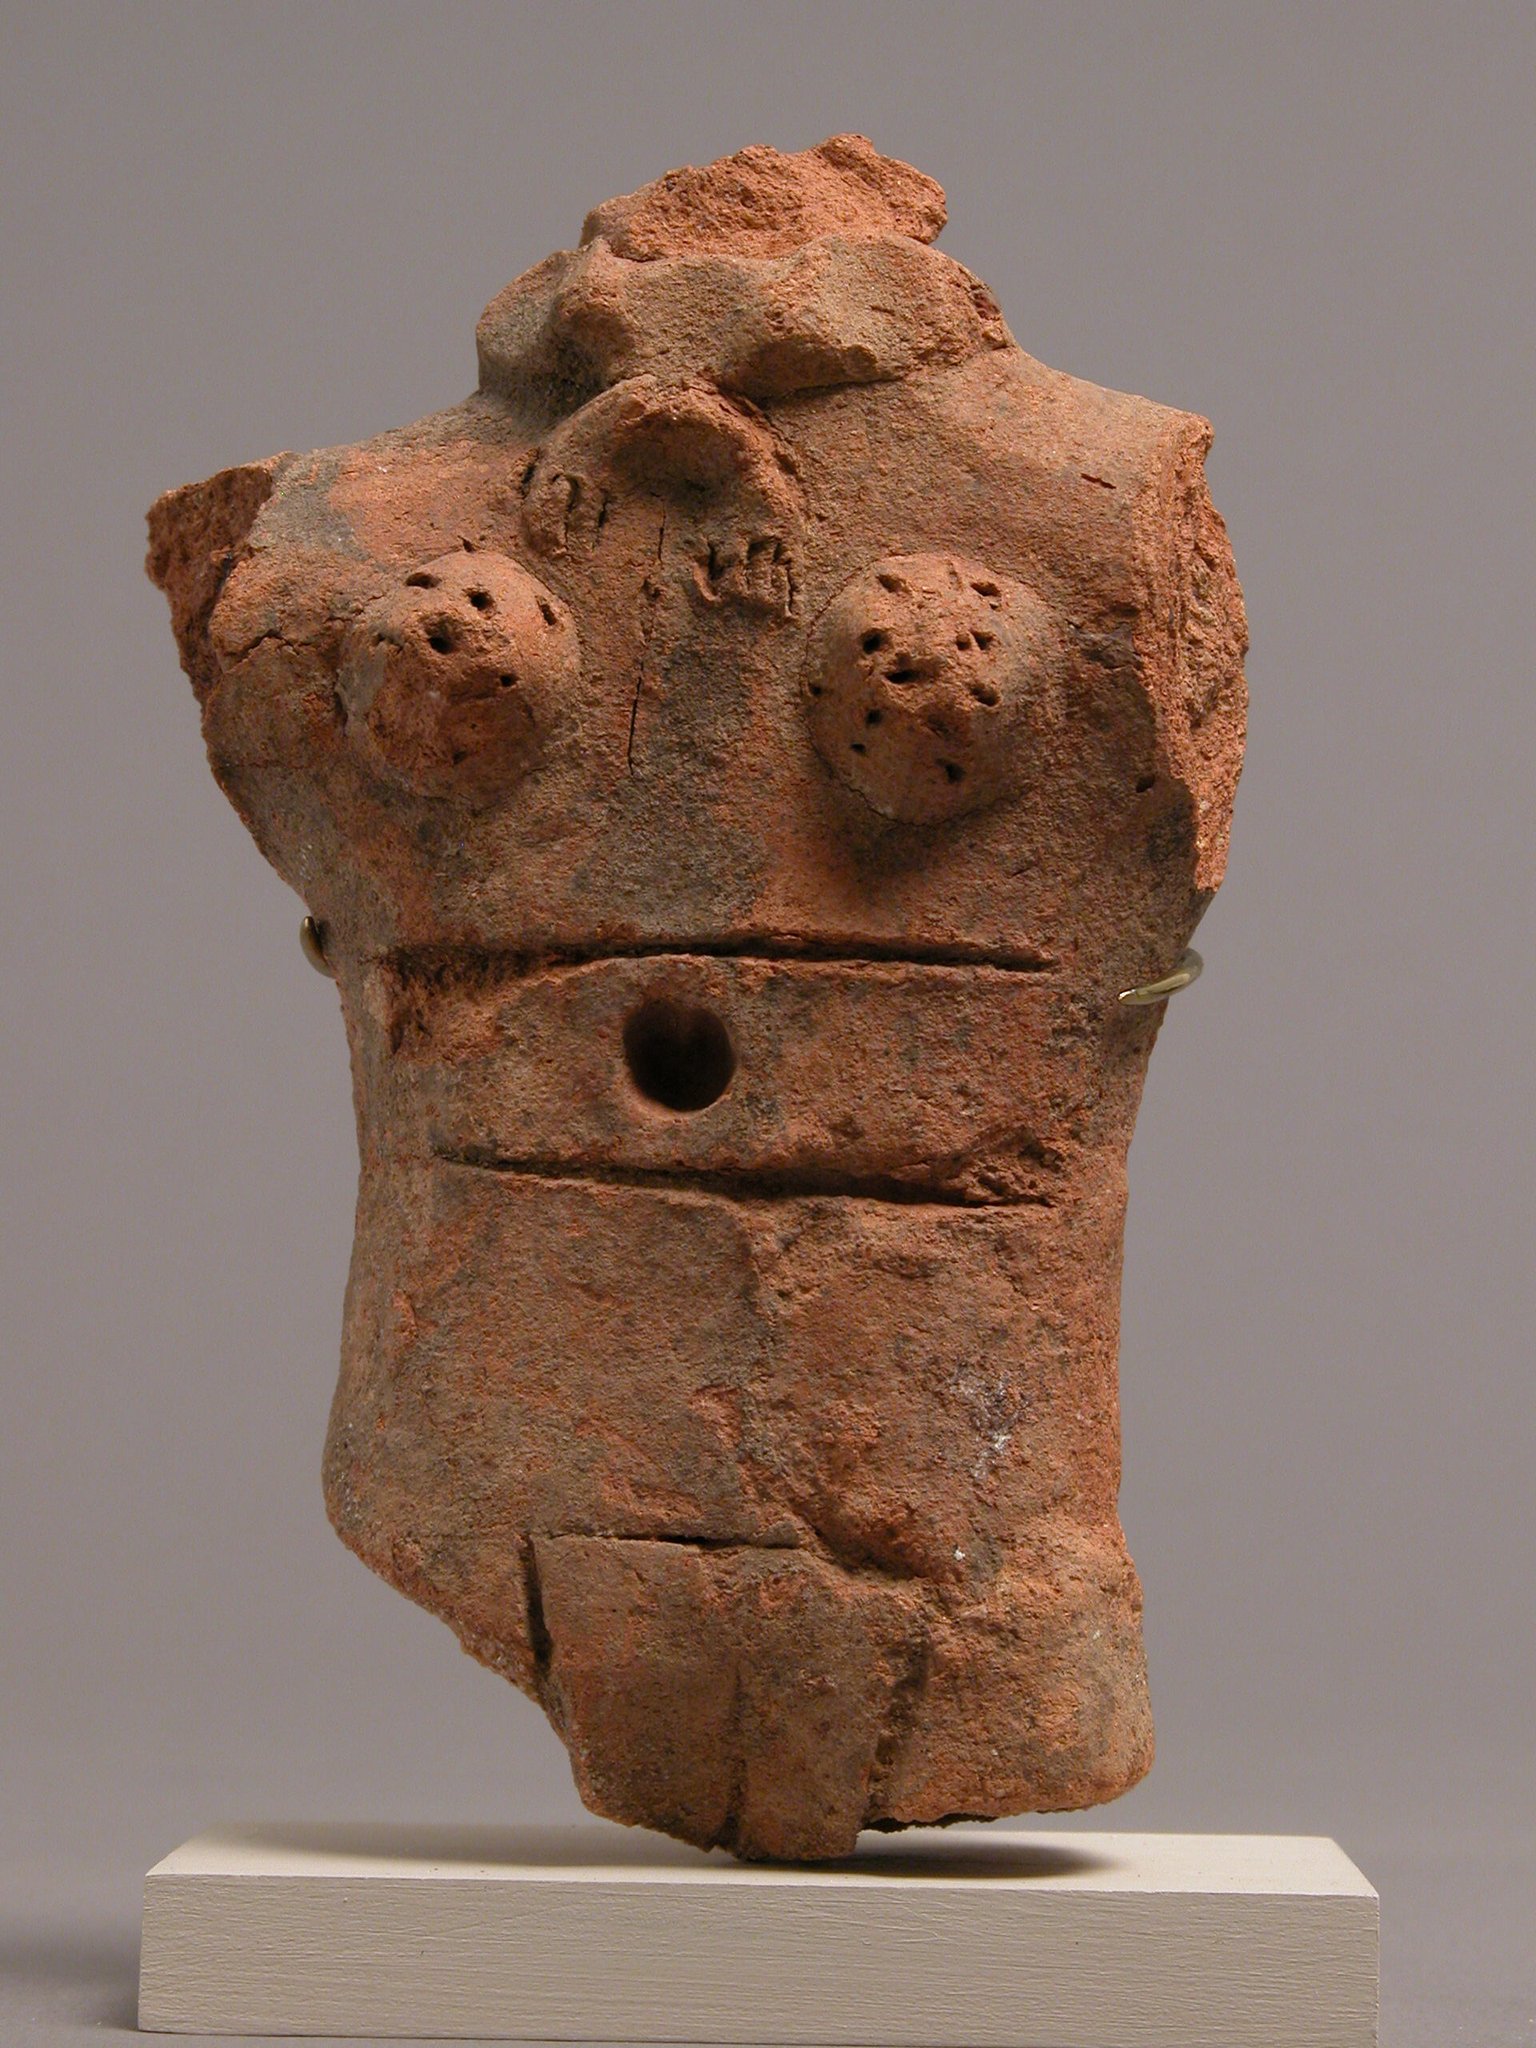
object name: statuette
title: Fragment of a Figure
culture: coptic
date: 301-700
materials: earthenware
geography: egypt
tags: women